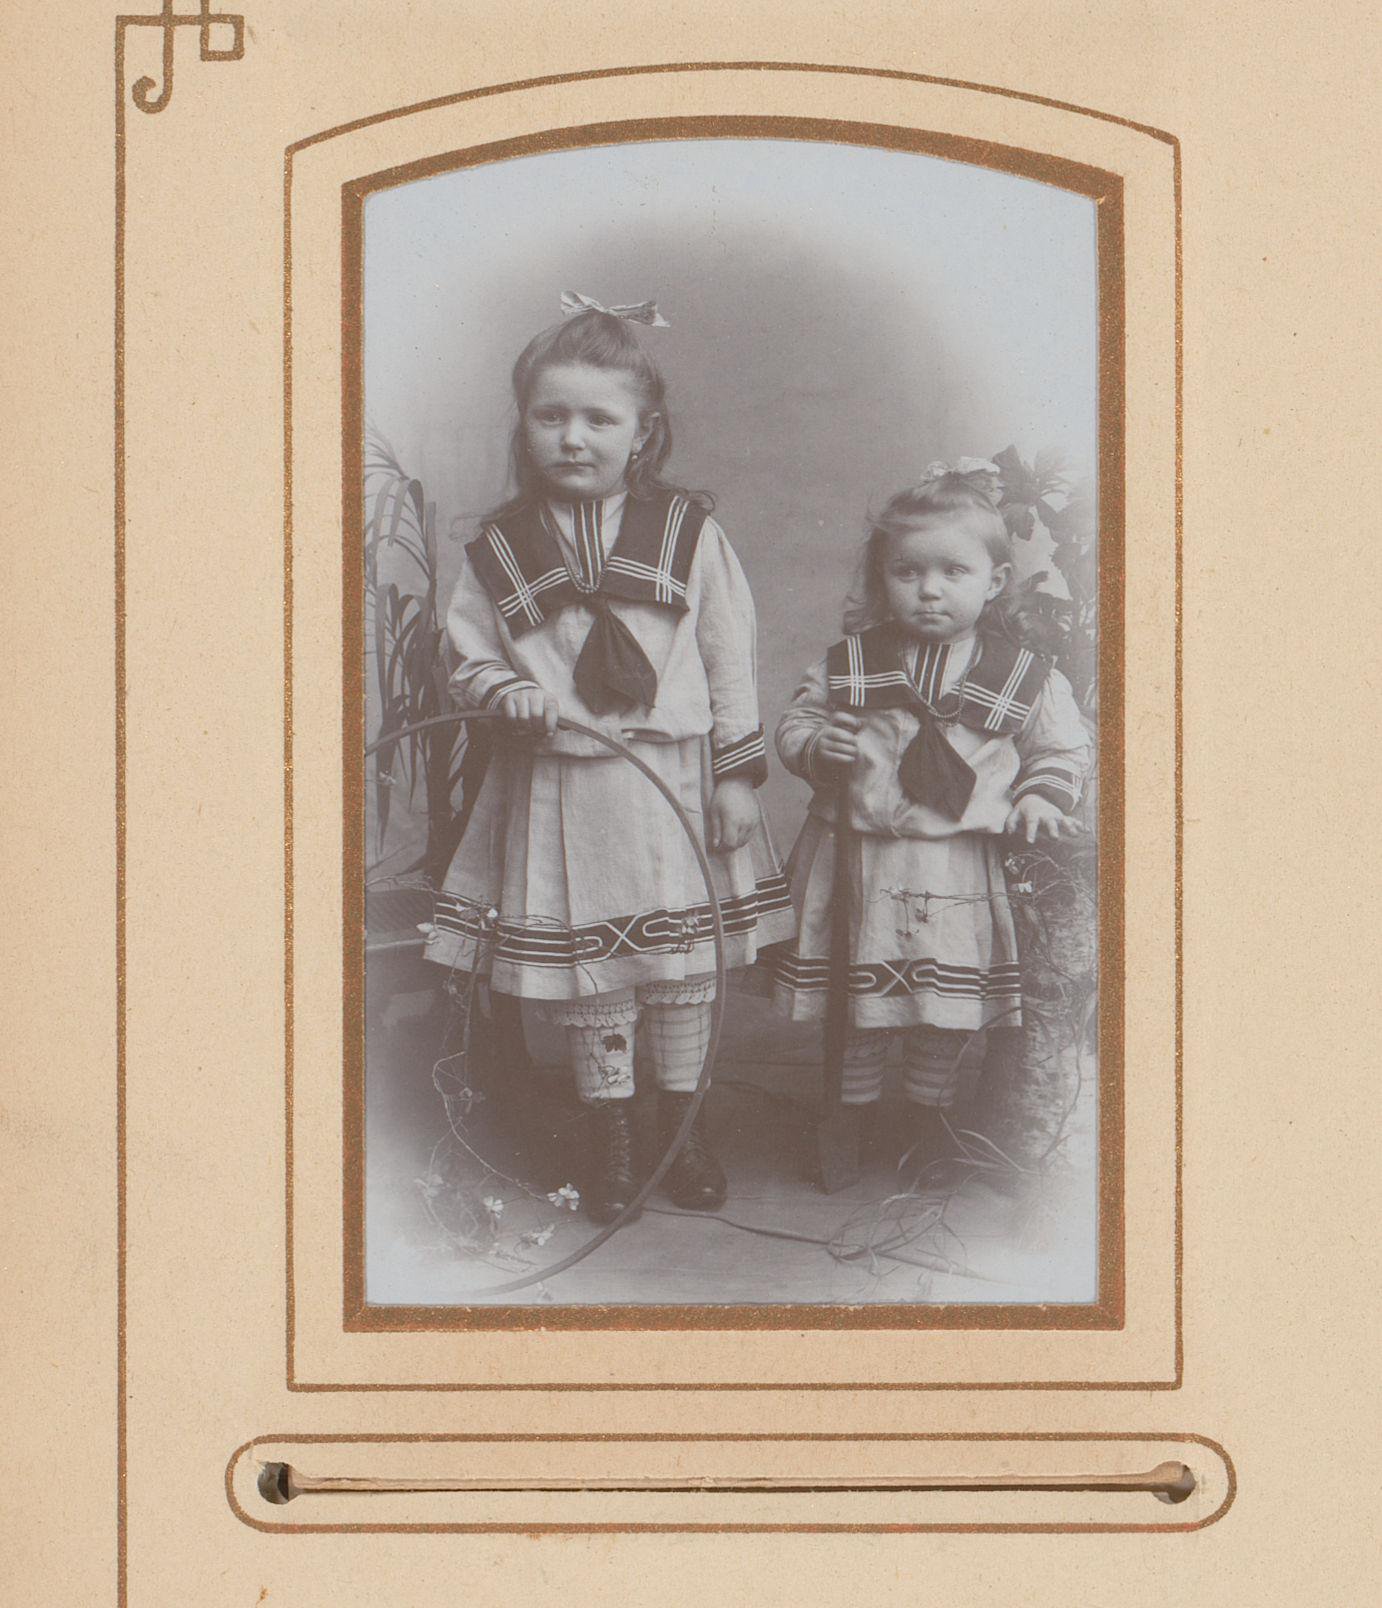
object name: carte de visite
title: Portret van twee meisjes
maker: m. kaufstein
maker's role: fotograaf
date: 1880-1910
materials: cardboard, photographic support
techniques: collodion silver print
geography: berlin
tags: historical persons - bb - woman, girl (child between toddler and youth)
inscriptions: inscription: ‘M. Kaufstein/ Berlin C./ Alte Schönhauserstr. 1/ Ecke Lothringenstr.’